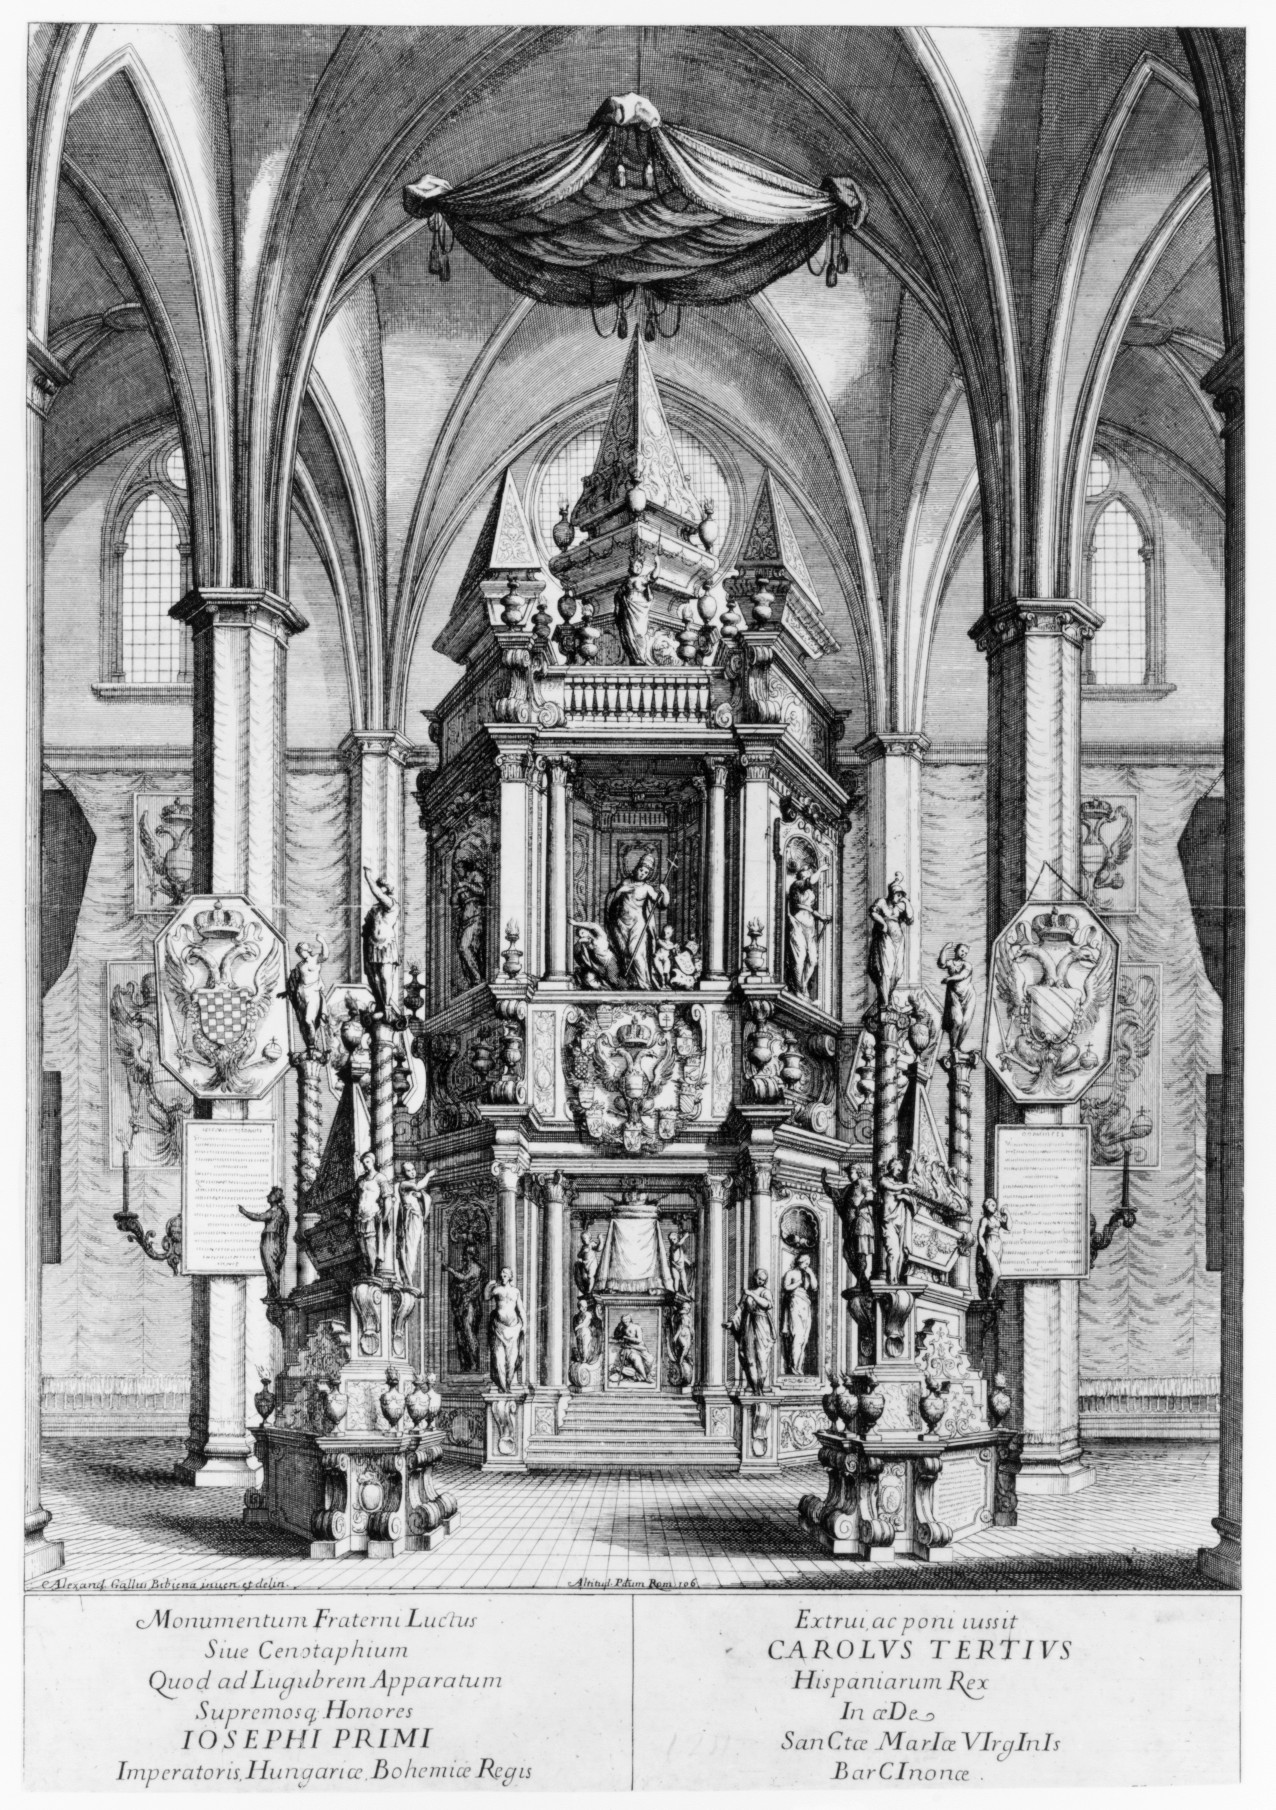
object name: print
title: Tomb of Joseph I, Emperor of Hungary, King of Bohemia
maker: alexander galli bibiena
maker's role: artist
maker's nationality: italian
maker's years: 1687-1769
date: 1700-1769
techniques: engraving, etching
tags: architecture,tombs,coat of arms